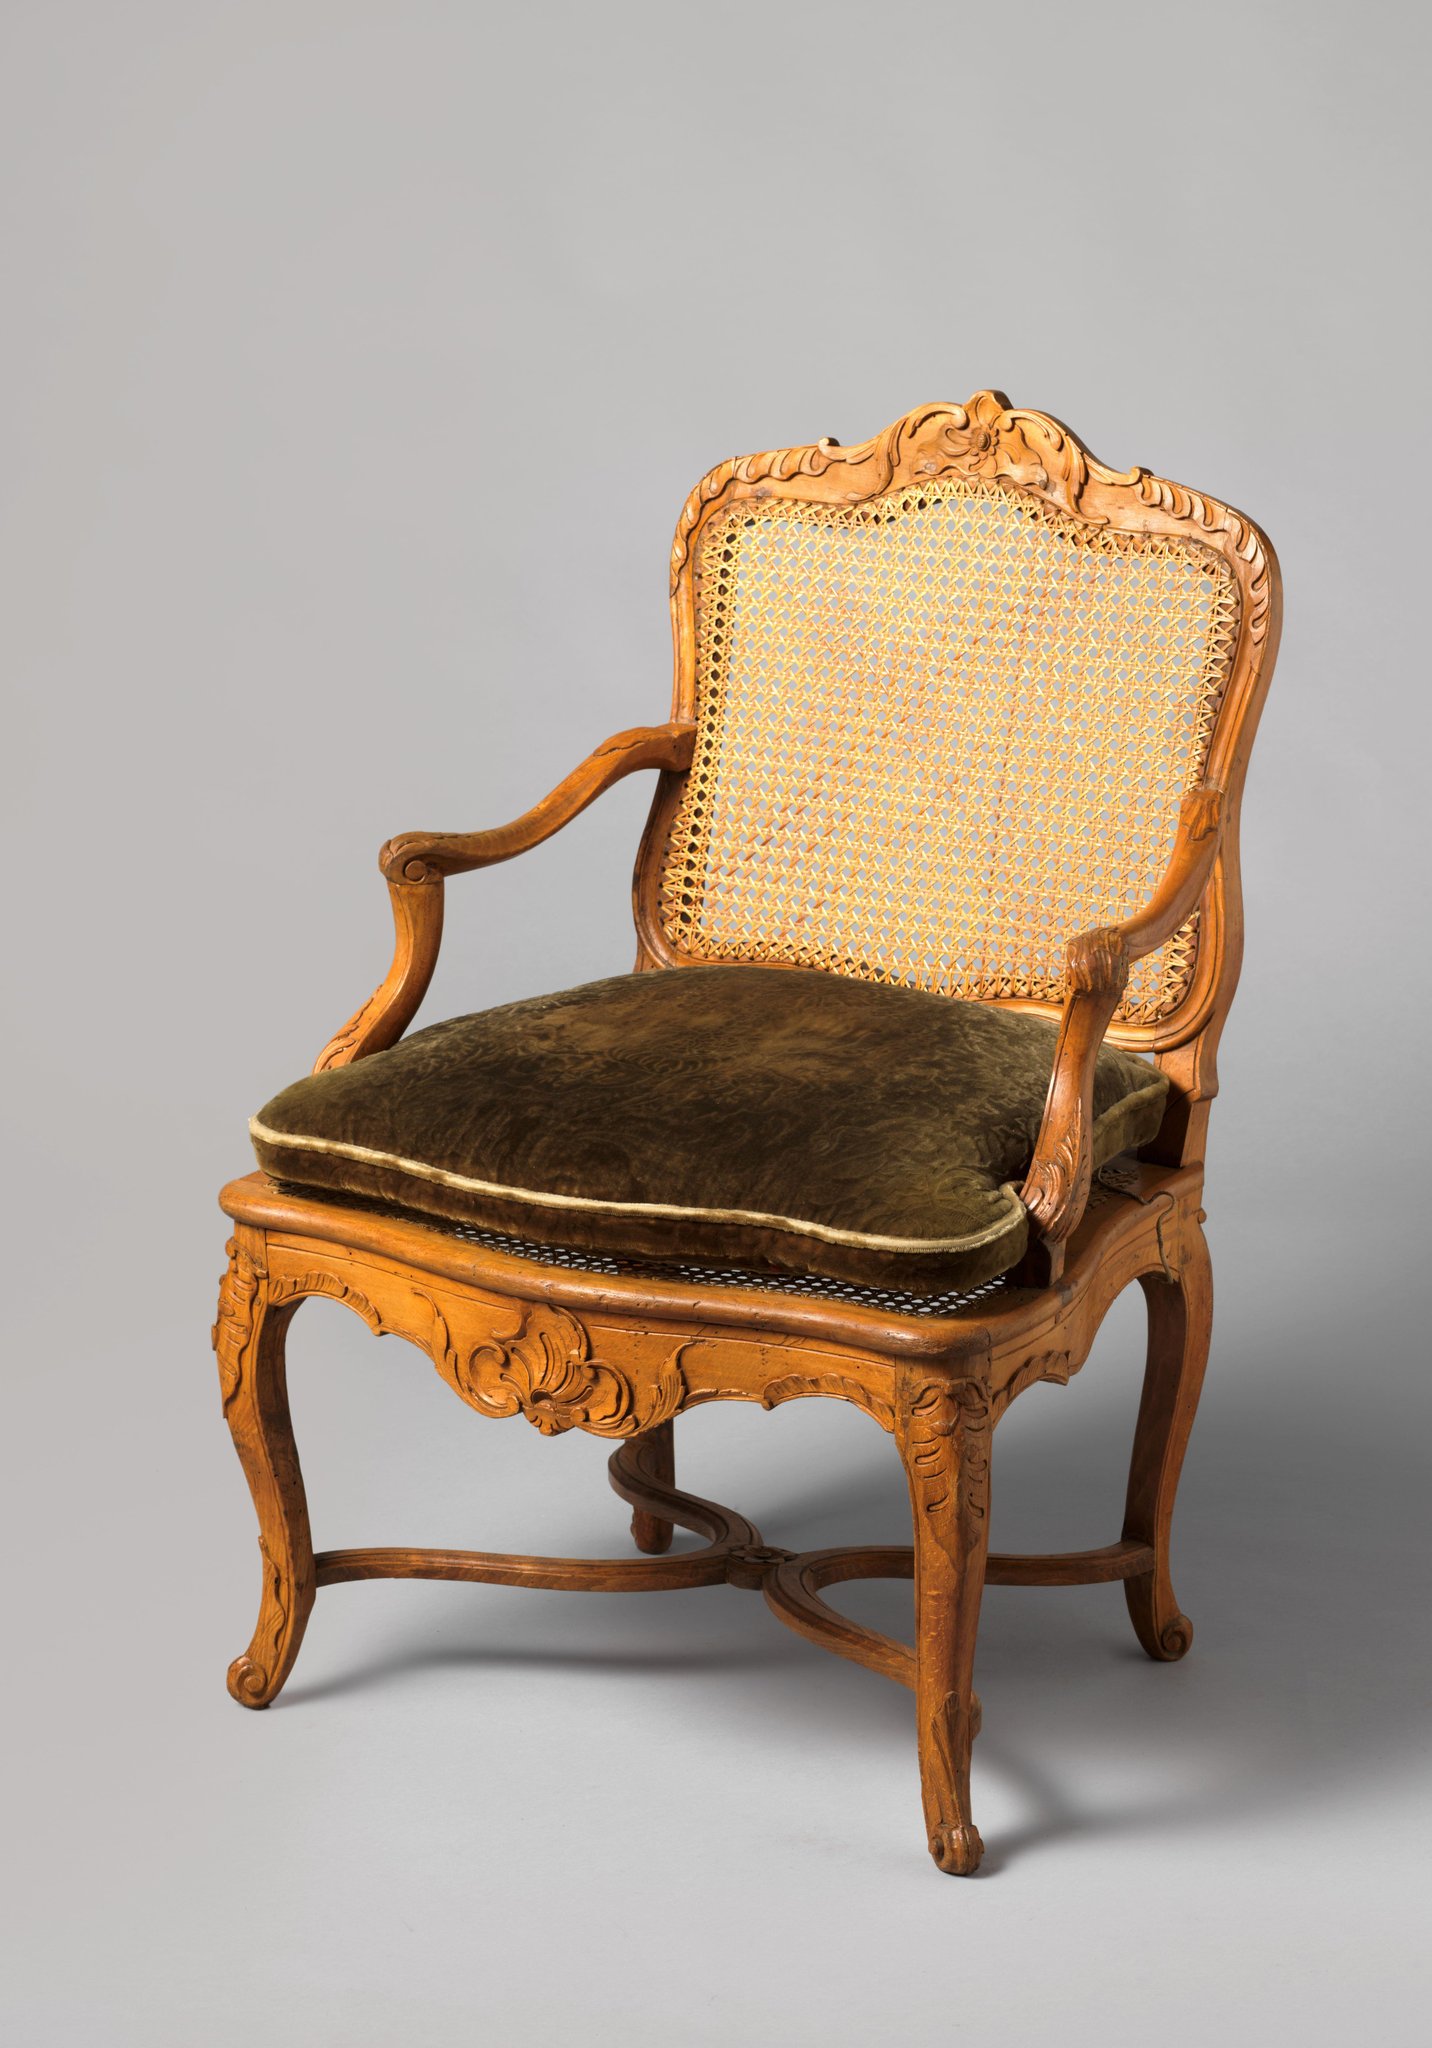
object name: suite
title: Armstoel van noten- en beukenhout met S-vormige overhoeks geplaatste poten; X-vormig kruis met rozet; gesneden bloem- en bladwerk, rug en zitting van riet, met los kussen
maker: Anonymous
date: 1750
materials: wood, textile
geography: france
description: Armstoel van noten- en beukenhout (ameublement) met S-vormige overhoeks geplaatste poten, verbonden door een geslingerd X-vormig kruis met rozet. Regels en dorpels en poten zijn versierd met gesneden bloem- en bladmotieven. Rug en zitting van gevlochten riet. Los kussen van groen geschoren triijp (modern). Zie ook: BK-16852-A,C,D.